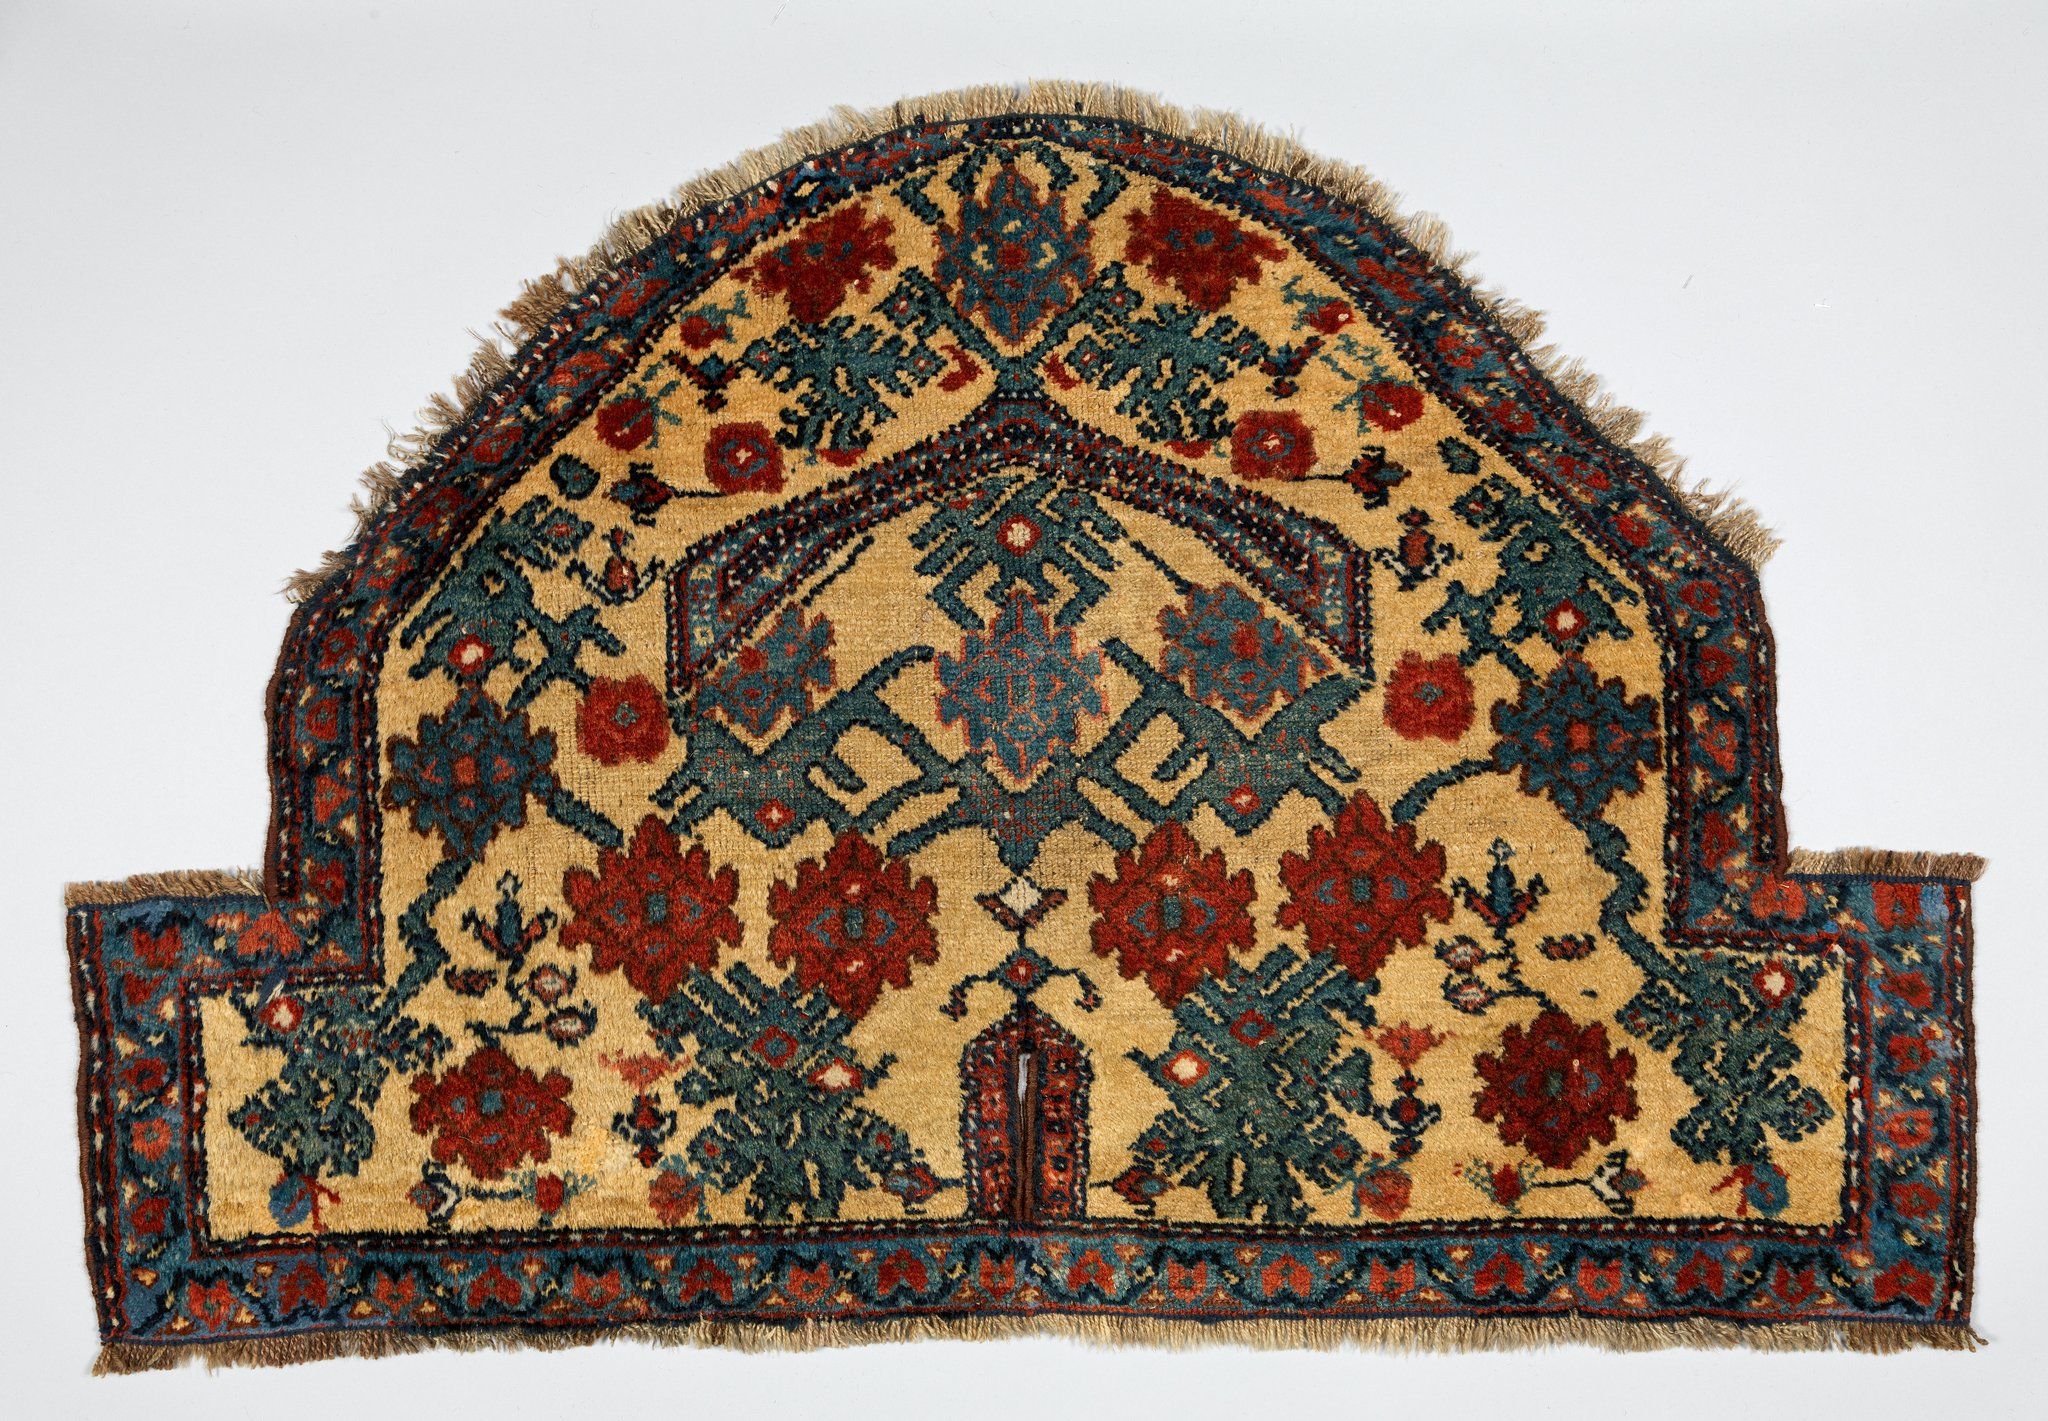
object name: saddle cover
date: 1876-1900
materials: wool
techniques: pile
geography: western iran